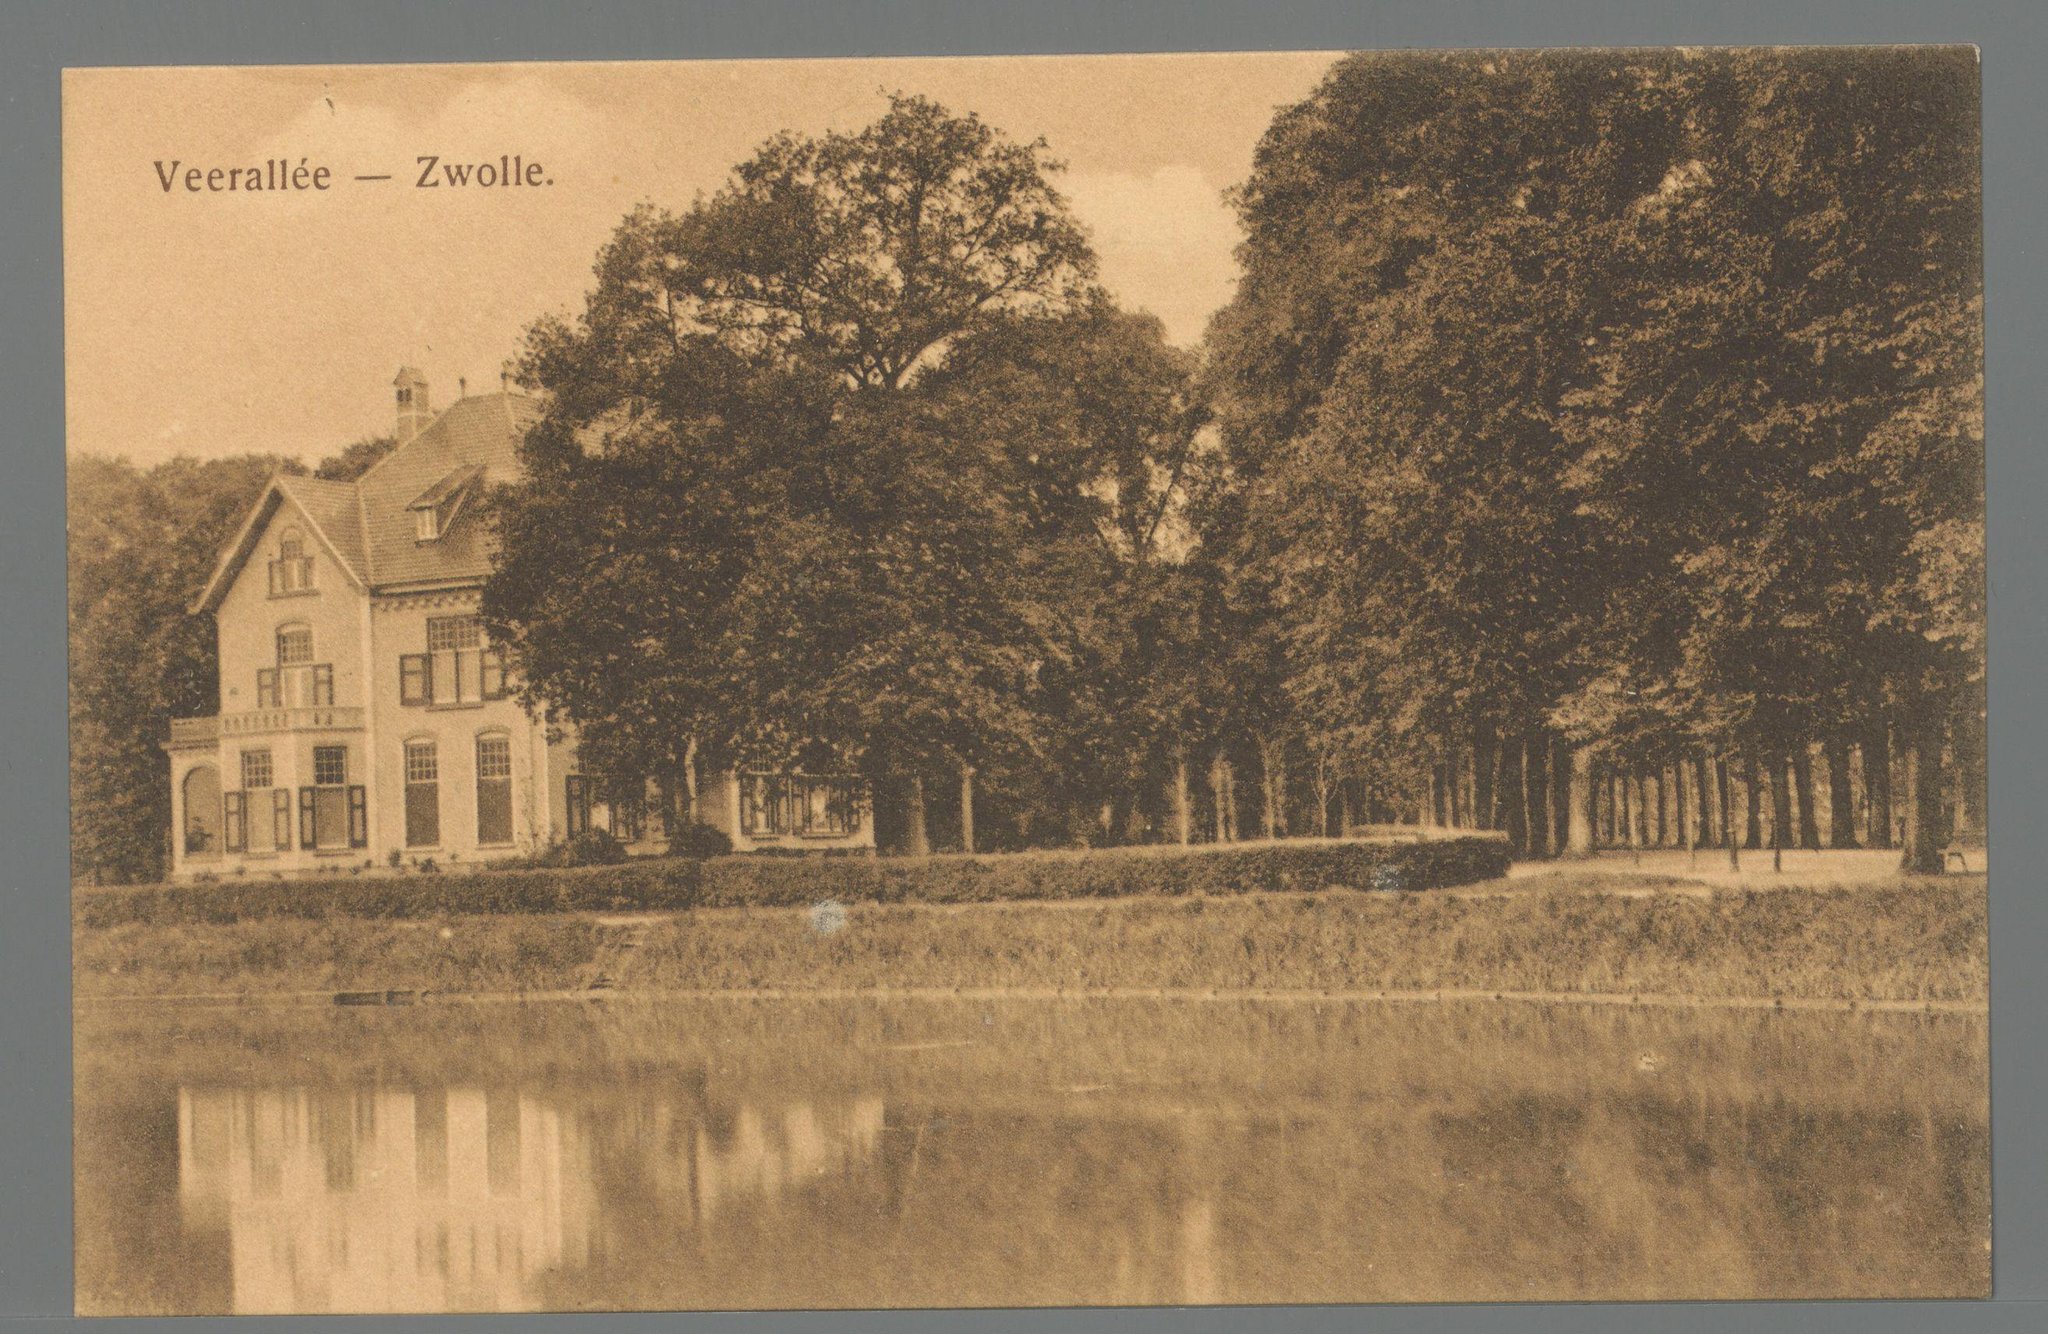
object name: ansichtkaart, prentbriefkaart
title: Veerallée - Zwolle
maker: Anonymous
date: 1905-1930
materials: cardboard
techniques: photograph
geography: zwolle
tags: canals, waters (in city), villa, street